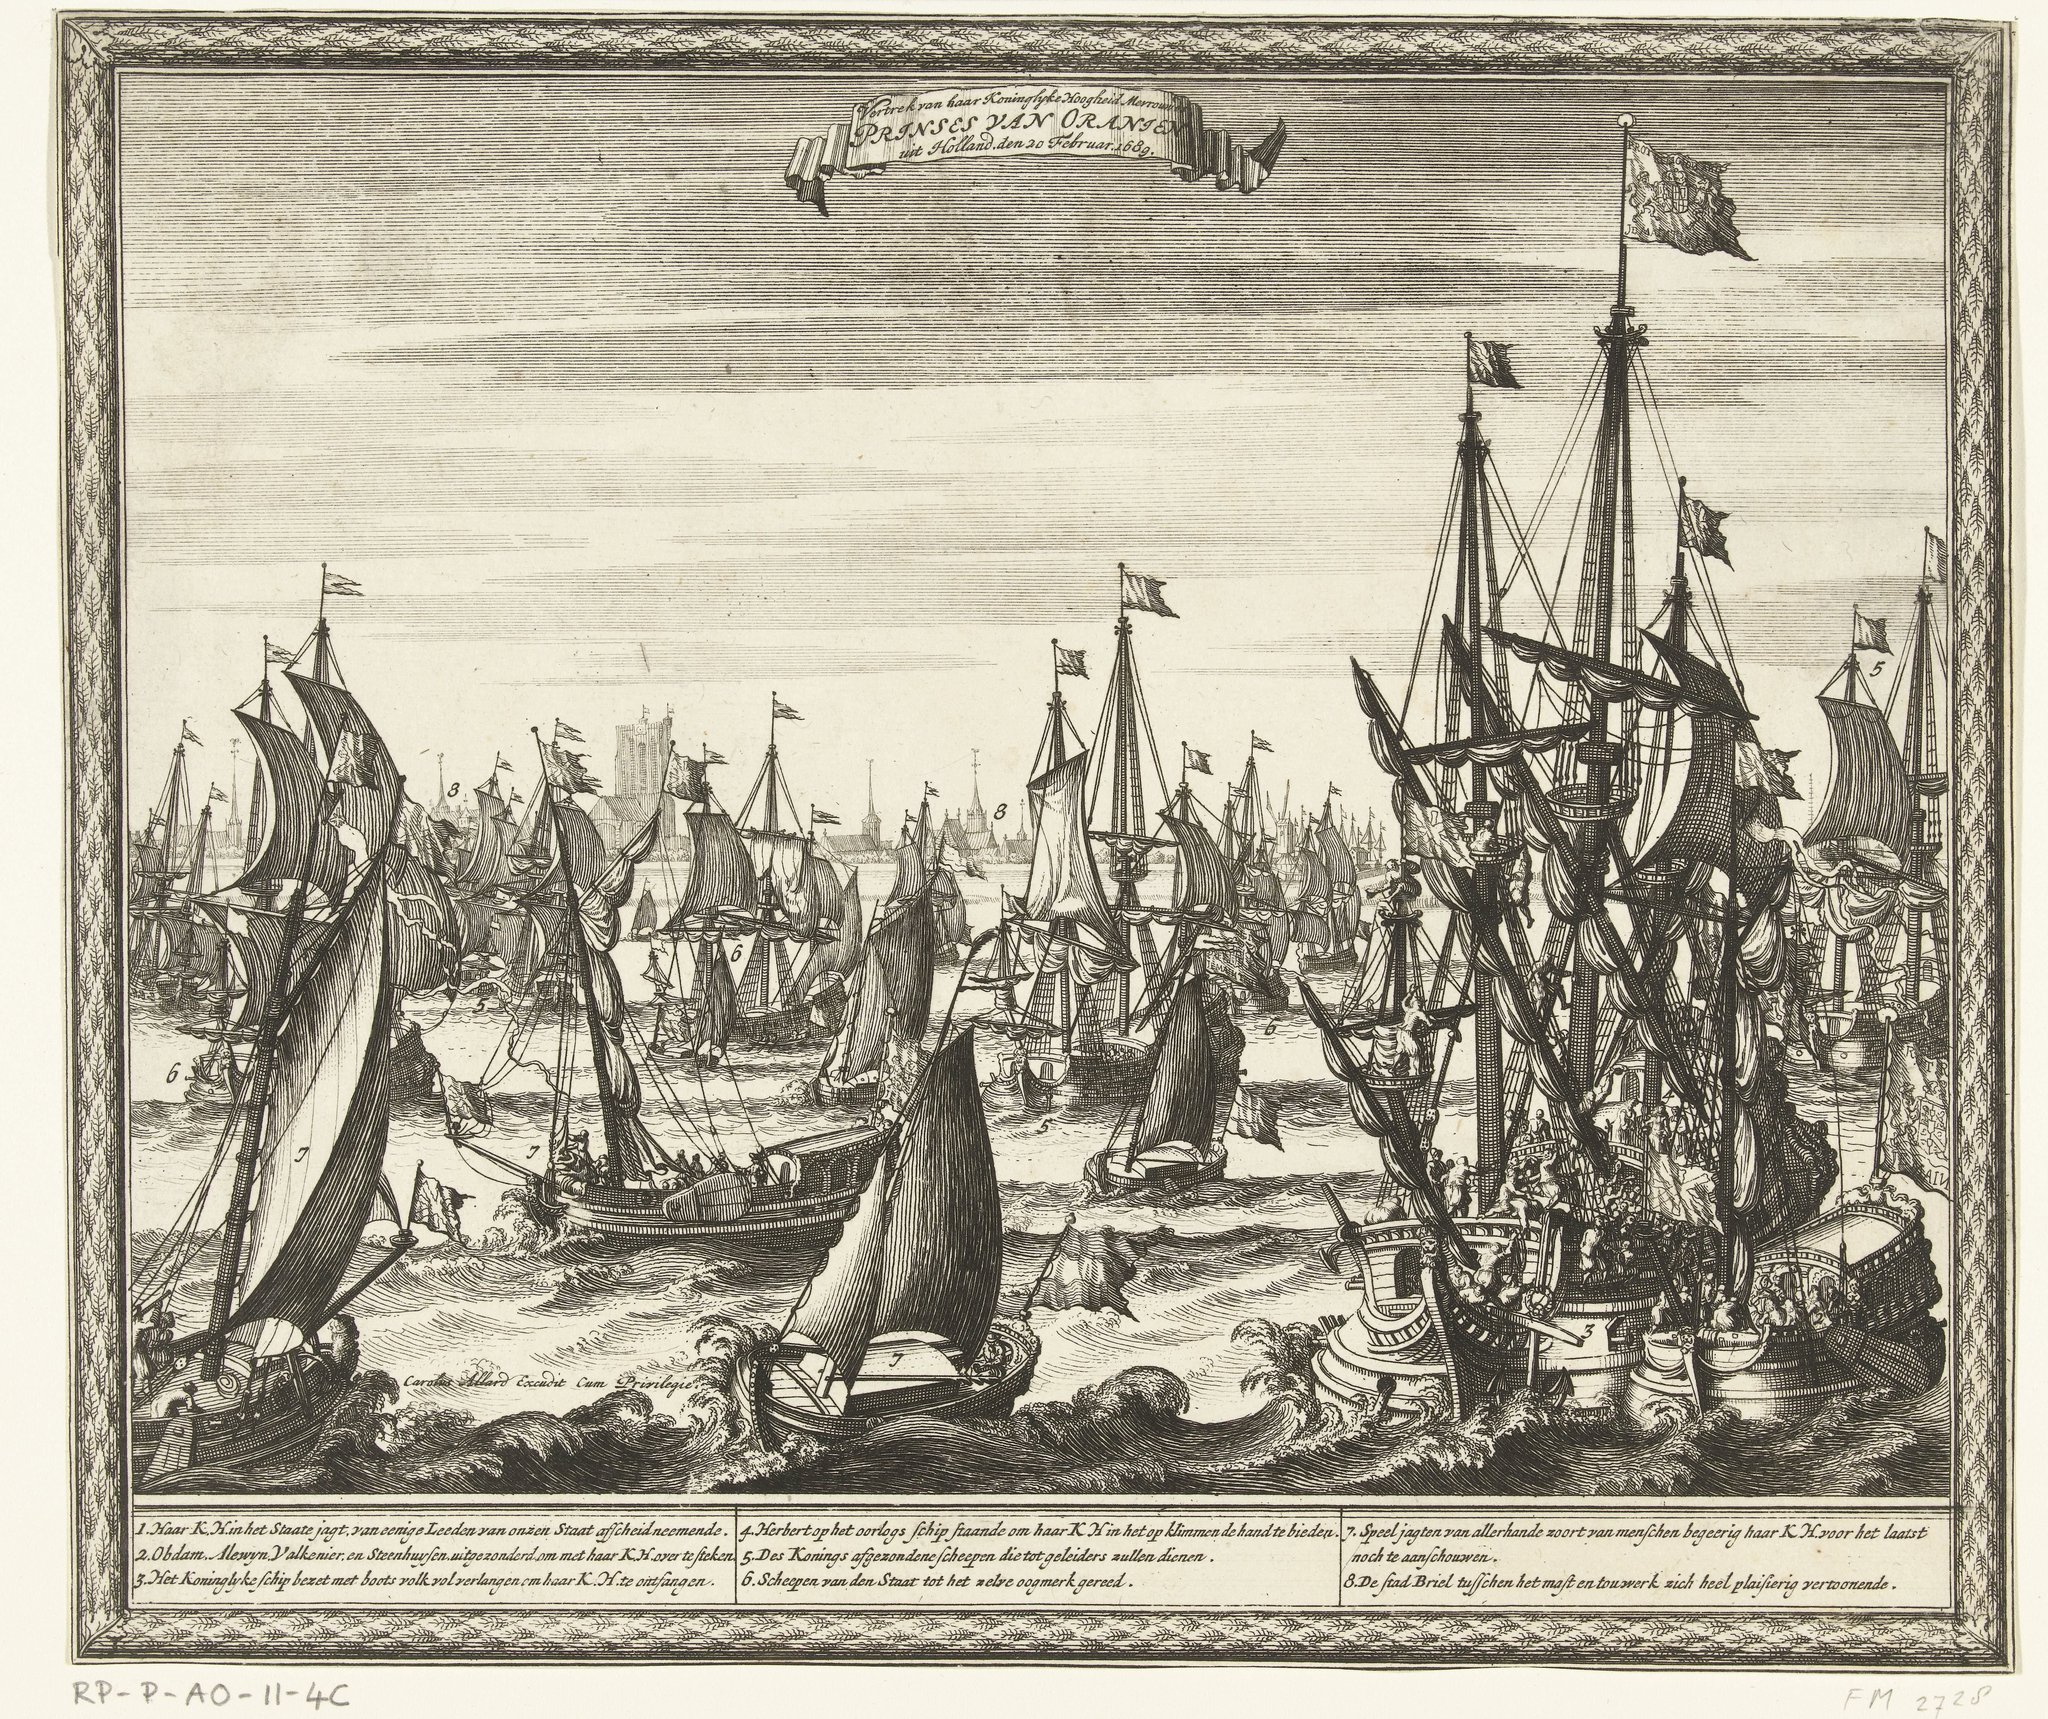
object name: print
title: Vertrek van Maria Stuart uit Holland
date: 1689-1691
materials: paper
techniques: etching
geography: amsterdam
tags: london, maria ii stuart (koningin van engeland, schotland en ierland), brielle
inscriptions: collector's mark: Lugt 2228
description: Gezicht op de vloot die Maria Stuart naar Engeland zal brengen. Op de achtergrond is Den Briel te zien. Rechts op de voorgrond vaart het schip met Maria Stuart die net afscheid neemt van haar Gedeputeerden. Met legenda van 1-8 in de ondermarge.